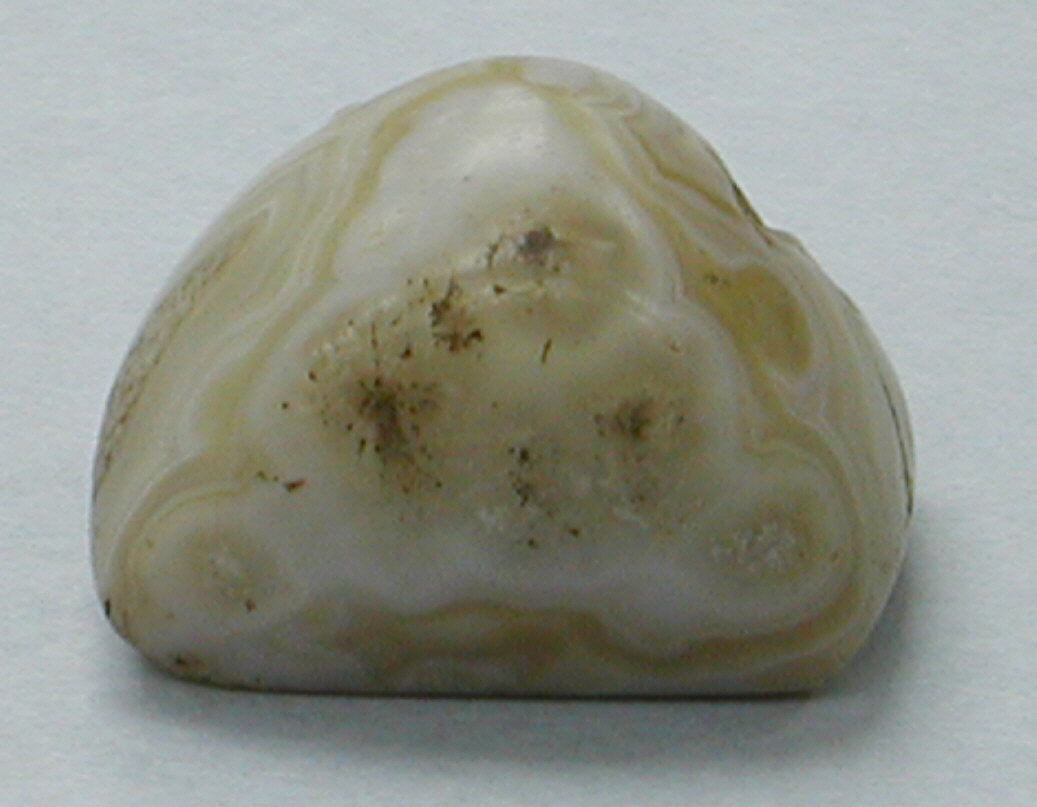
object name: ritual stone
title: Stone Pulidor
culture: mexican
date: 1501-1600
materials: stone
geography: mexico